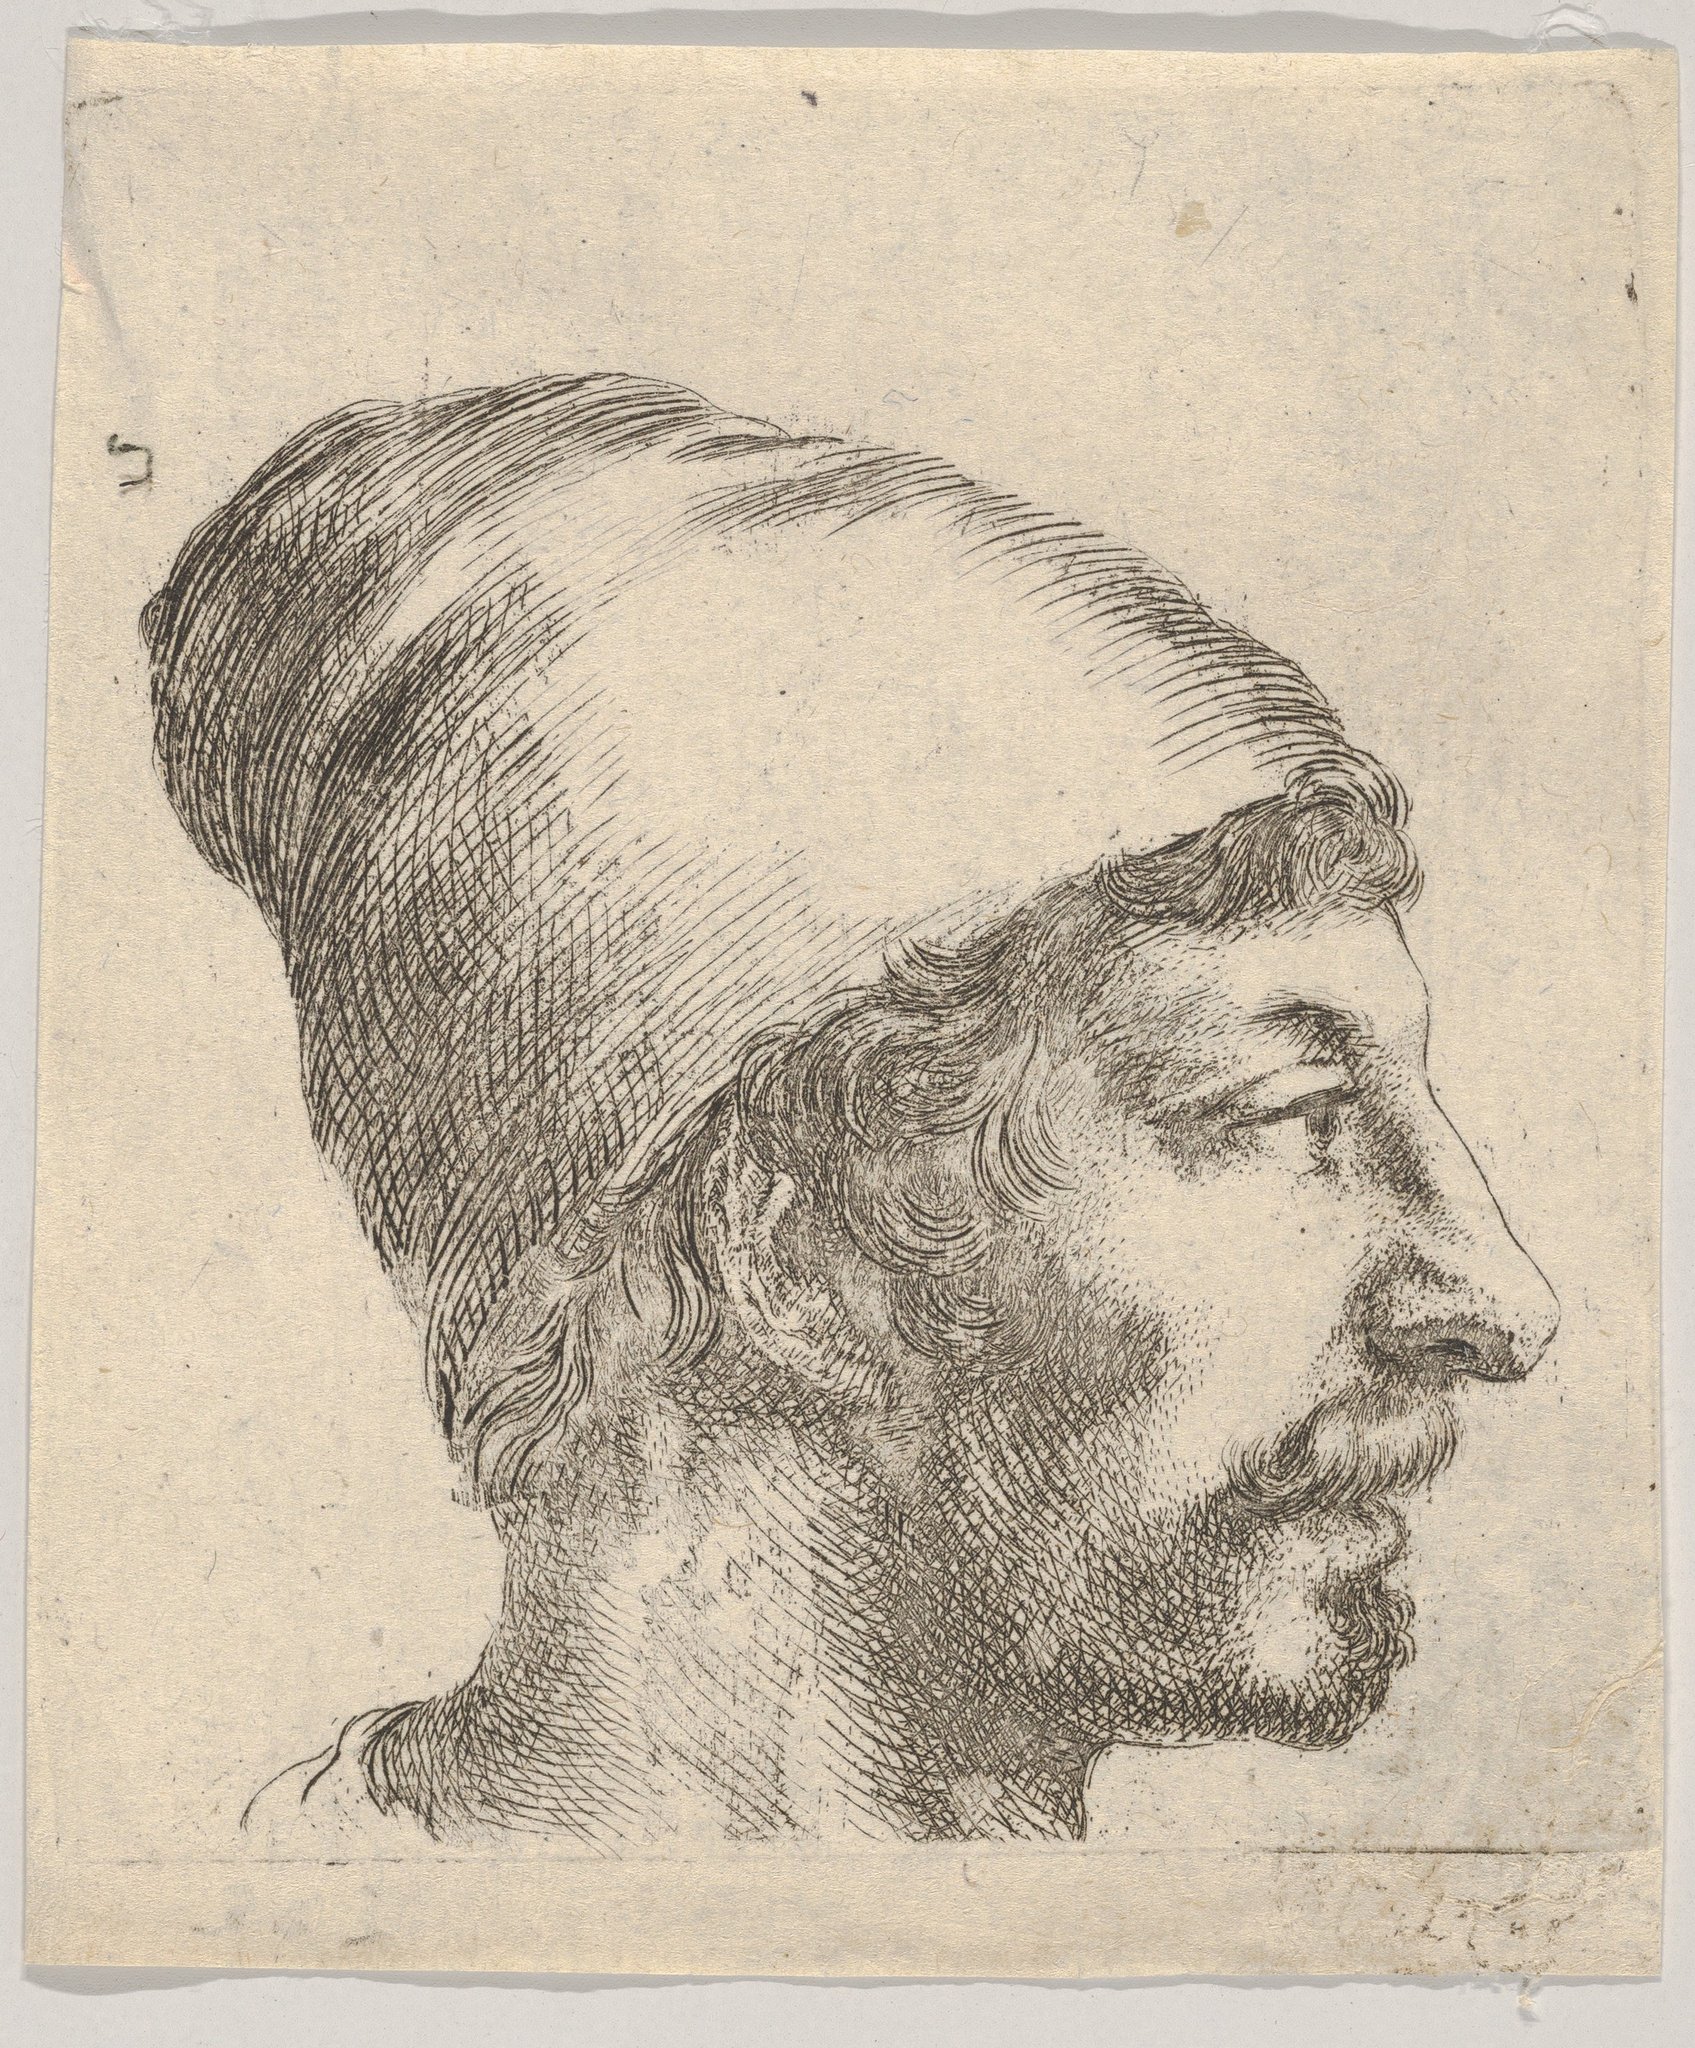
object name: print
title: Plate 38: Head of a man with a moustache and cap, facing right in profile, from "Various Portraits" (Recueil de diverses pièces servant à l'art de portraiture)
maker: stefano della bella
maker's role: artist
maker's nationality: italian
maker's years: 1610-1664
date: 1647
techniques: etching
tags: men,profiles